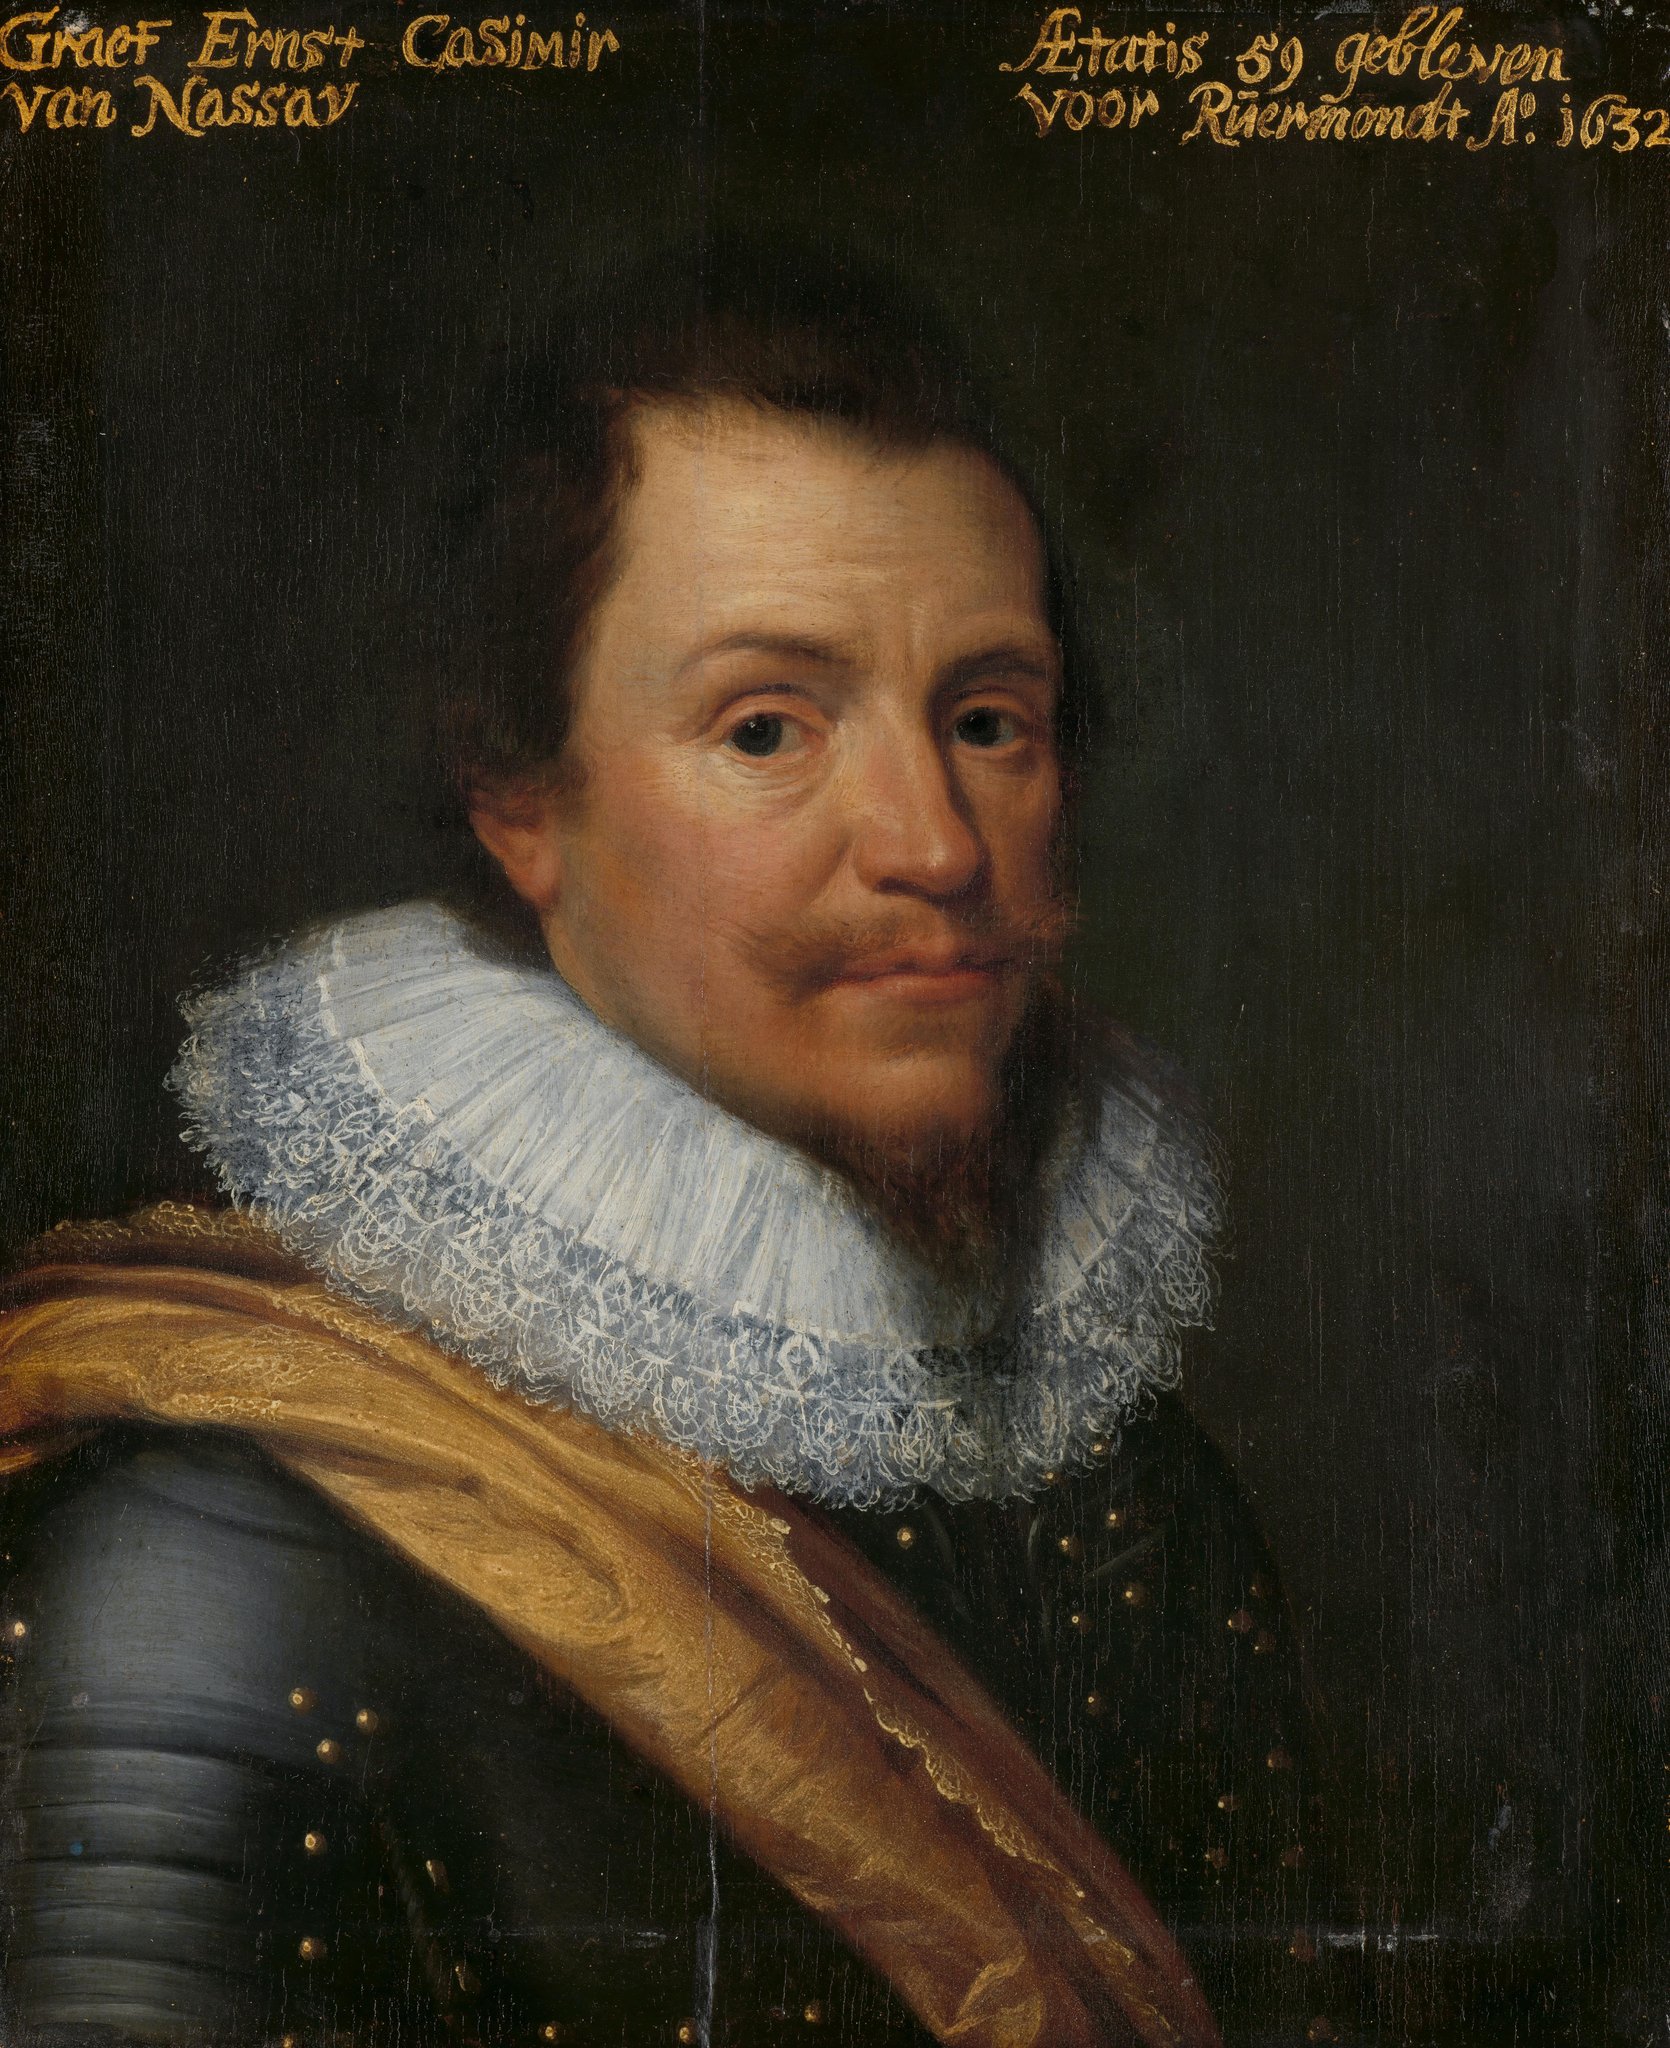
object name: painting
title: Portrait of Ernst Casimir (1573-1632), Count of Nassau-Dietz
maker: michiel jansz van mierevelt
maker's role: draughtsman, painter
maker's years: 1567-1641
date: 1623-1633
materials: oil, panel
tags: ernst casimir graaf van nassau-dietz, historical persons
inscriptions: inscription, top: ‘Graef Ernst Casimir van Nassau / Ætatis 59 gebleven voor Ruermondt Aº 1632’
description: These portraits were originally displayed at Honselaarsdijk, the palace built by Stadholder Frederick Henry and his wife Amalia in the 1620s near The Hague. In the style of European courts of the day, one of the palace rooms was lined with portraits of ancestors, relatives and celebrities past and present. Many of these personalities played a role in the Eighty Years War: members of the Nassau family and other commanders of the Dutch Republic's army, officers of the French and English allies and leading Spanish generals. A remarkable aspect is the number of foreigners who fought for the Dutch. The Republic's army enjoyed an international reputation and attracted young noblemen from abroad. For them, the war was a career opportunity.